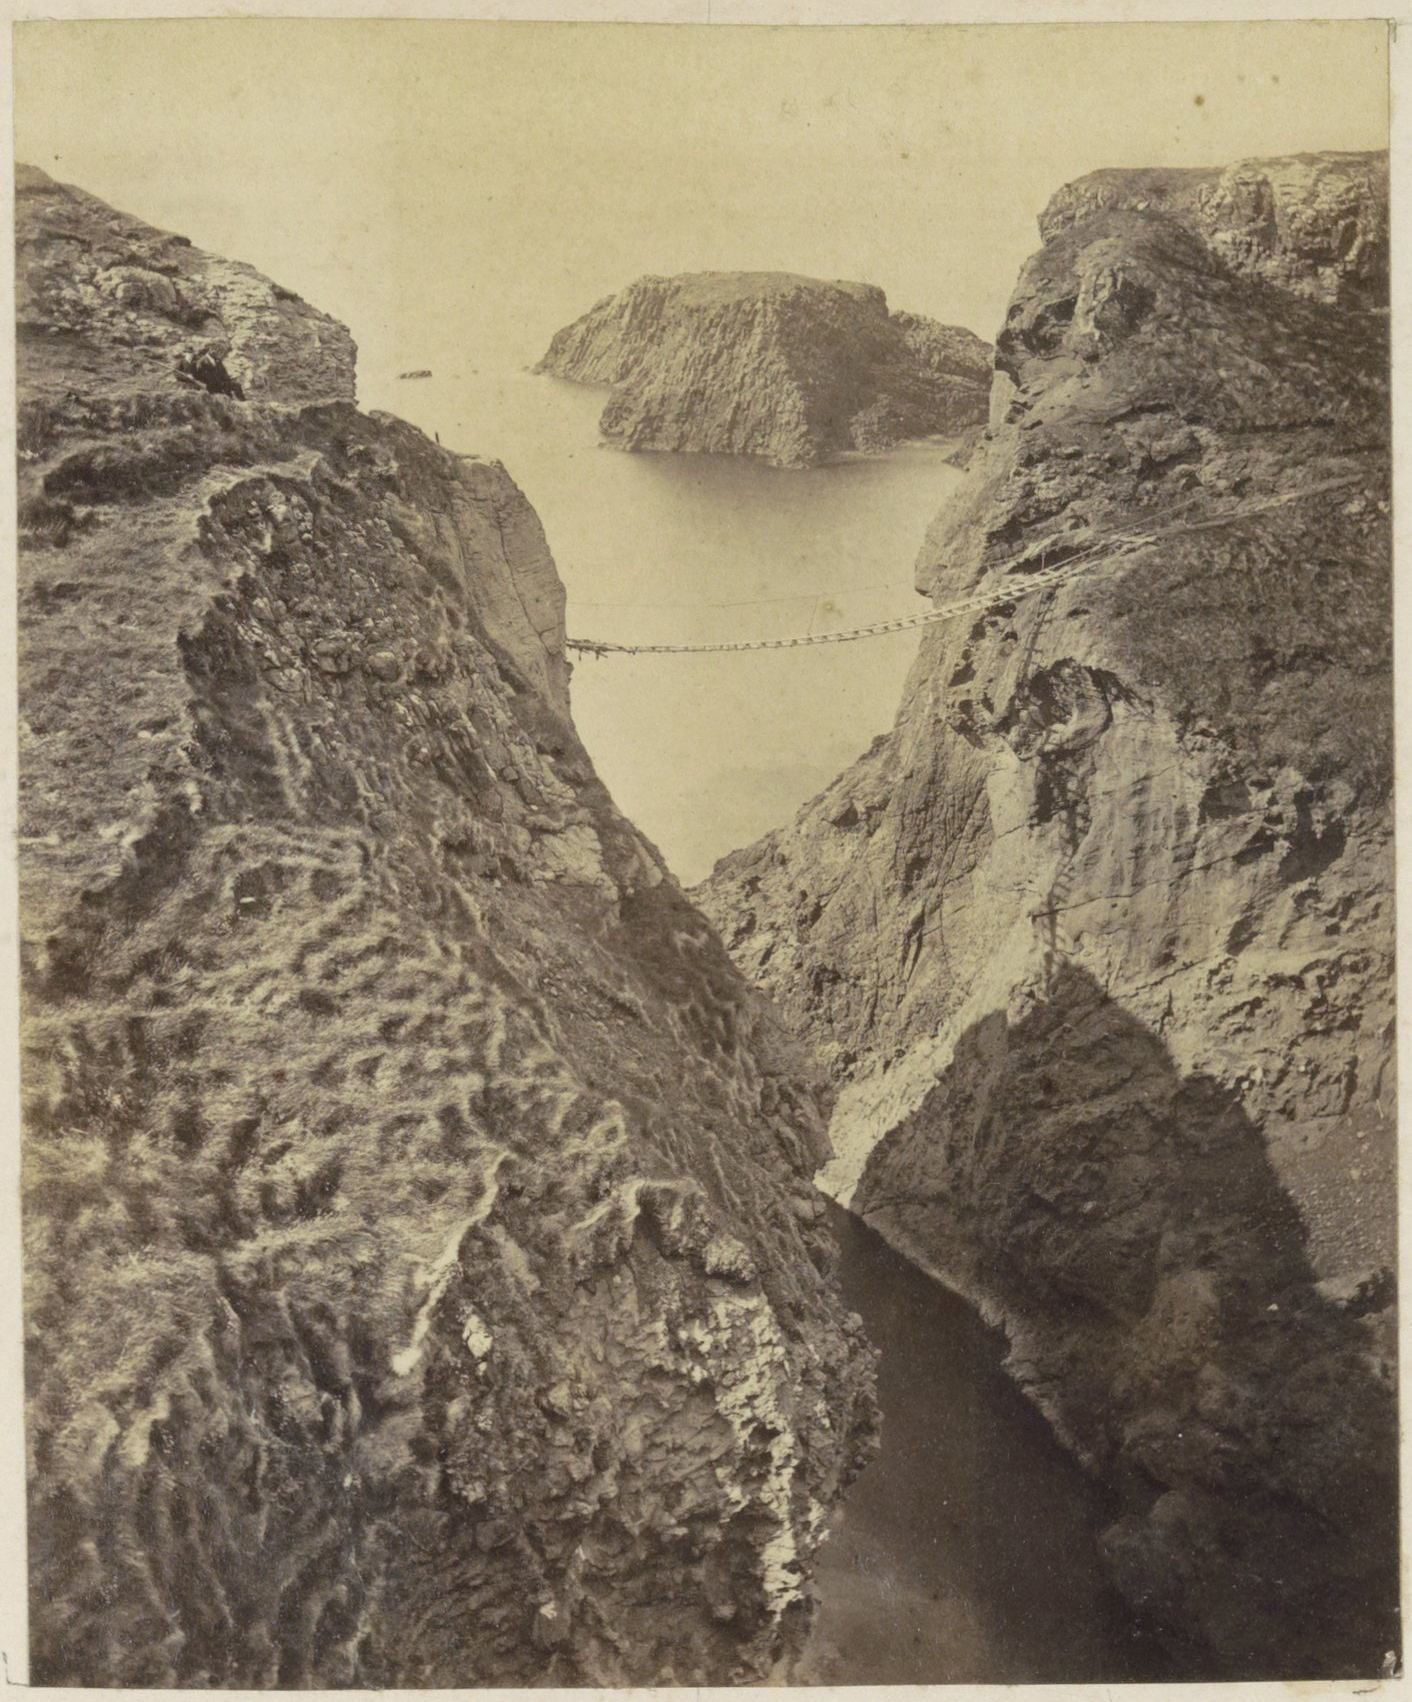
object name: photograph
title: Rotsformaties aan de Engelse kust met een hangbrug voor voetgangers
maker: Anonymous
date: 1850-1870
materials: paper, photographic support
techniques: albumen print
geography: england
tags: suspension bridge, landscape with bridge, viaduct or aqueduct, rock-formations, coast, england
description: Onderdeel van Album met foto's van bezienswaardigheden en landschappen in Engeland en van kunst.